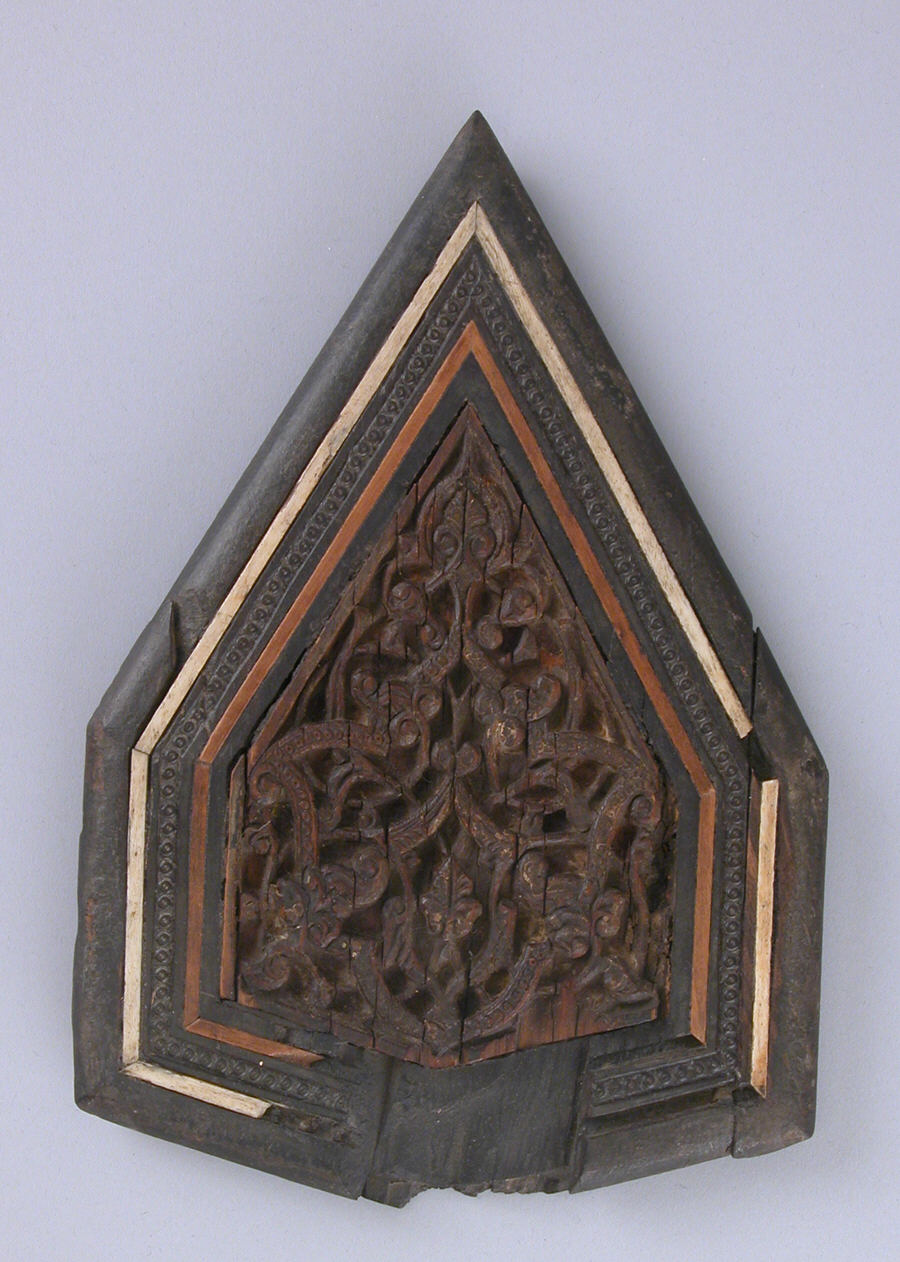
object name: panel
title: Panel from a Minbar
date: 1201-1400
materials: wood, ivory, paint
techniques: carving, inlay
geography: egypt